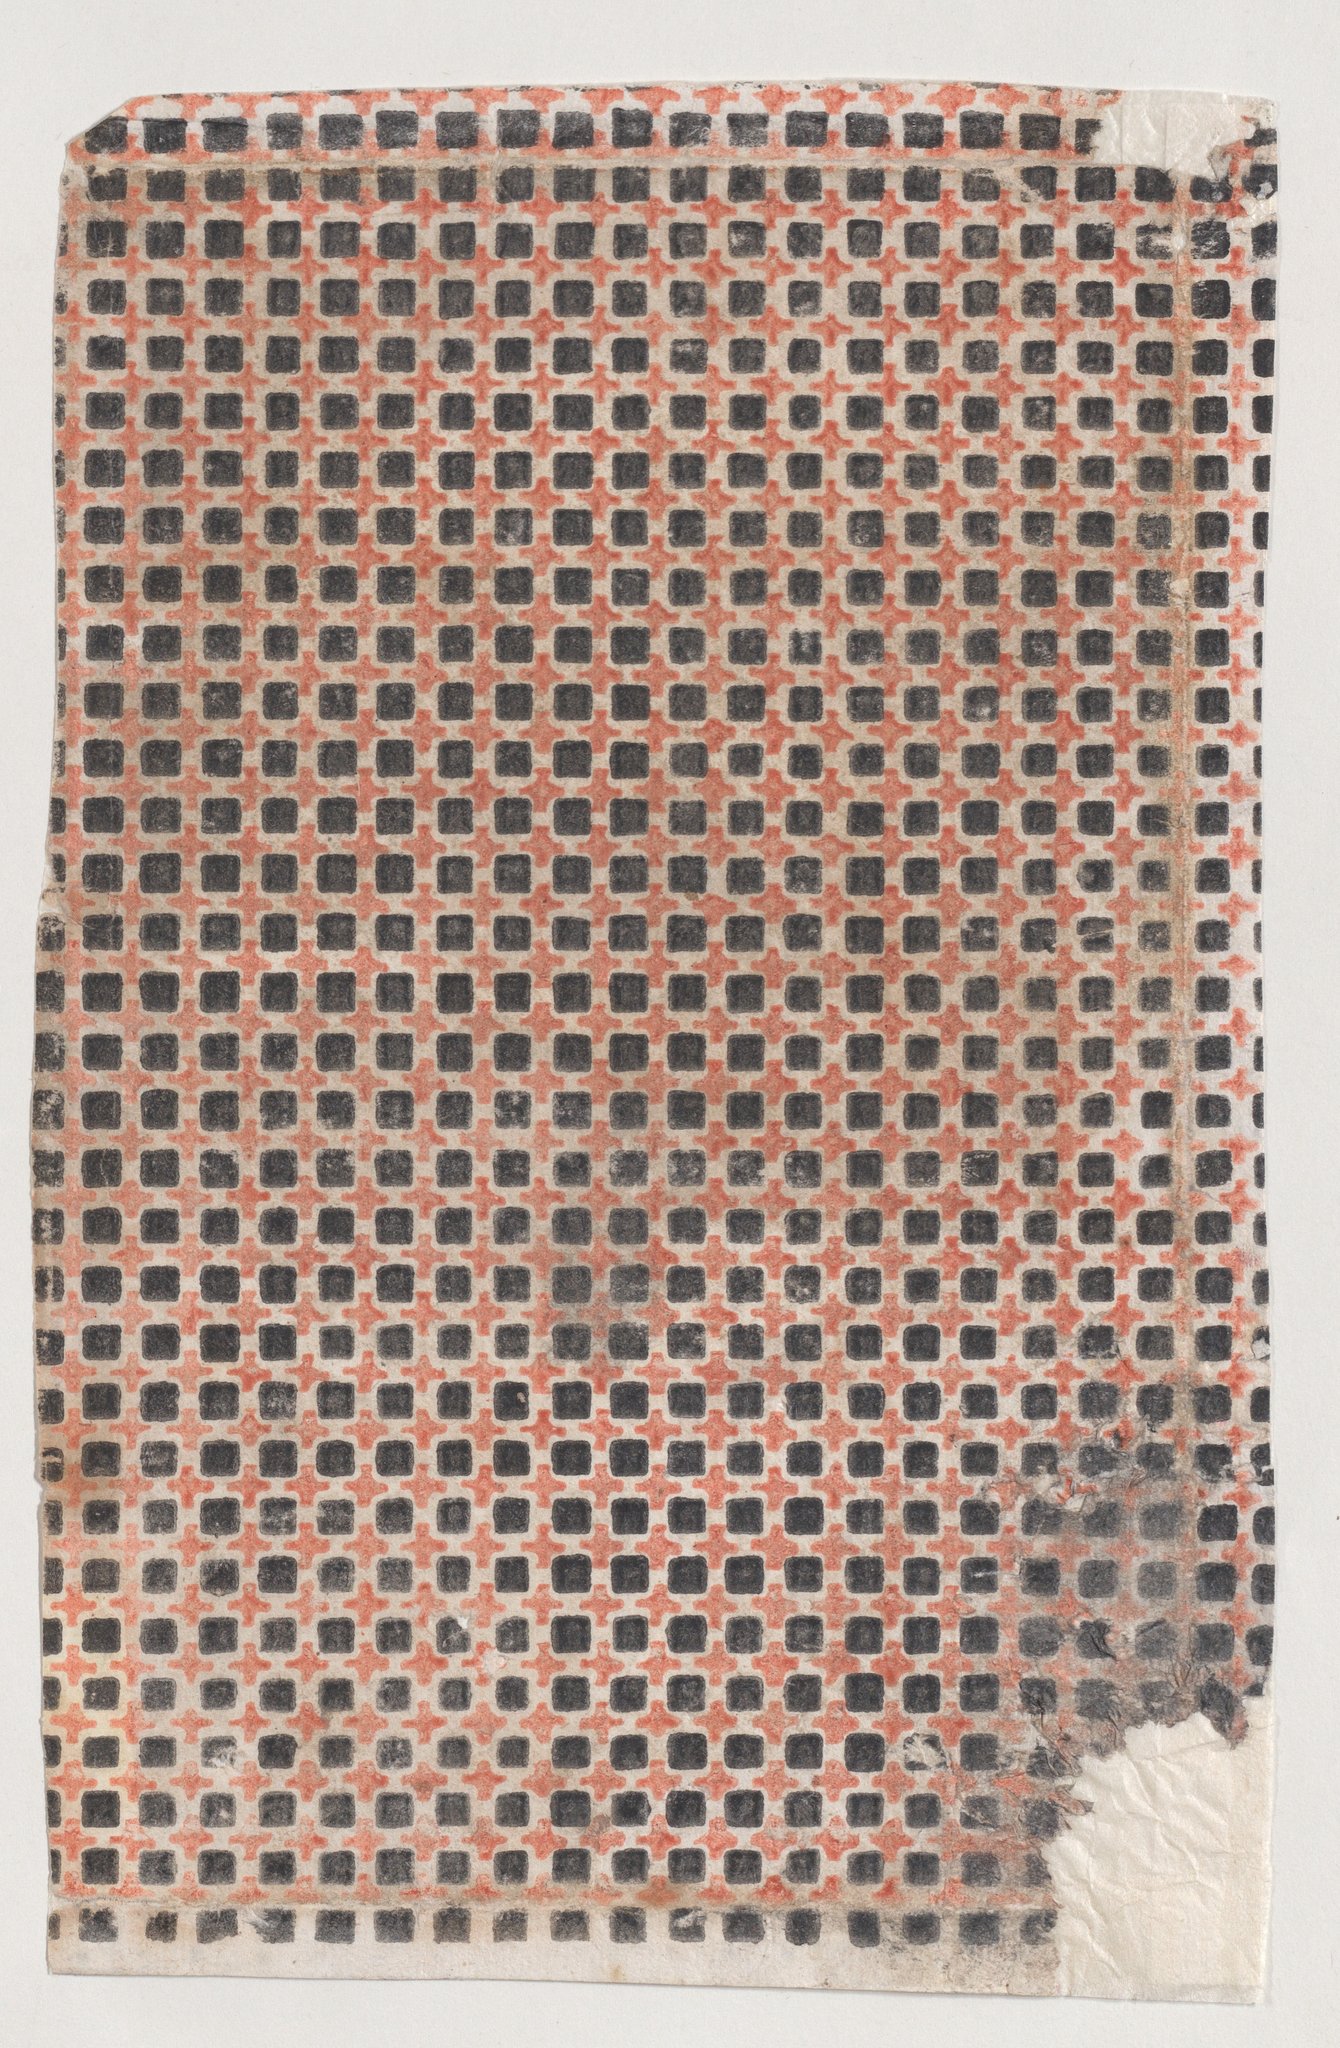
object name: print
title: Sheet with overall pattern of squares and crosses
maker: Anonymous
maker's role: artist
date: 1801-1900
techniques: relief print